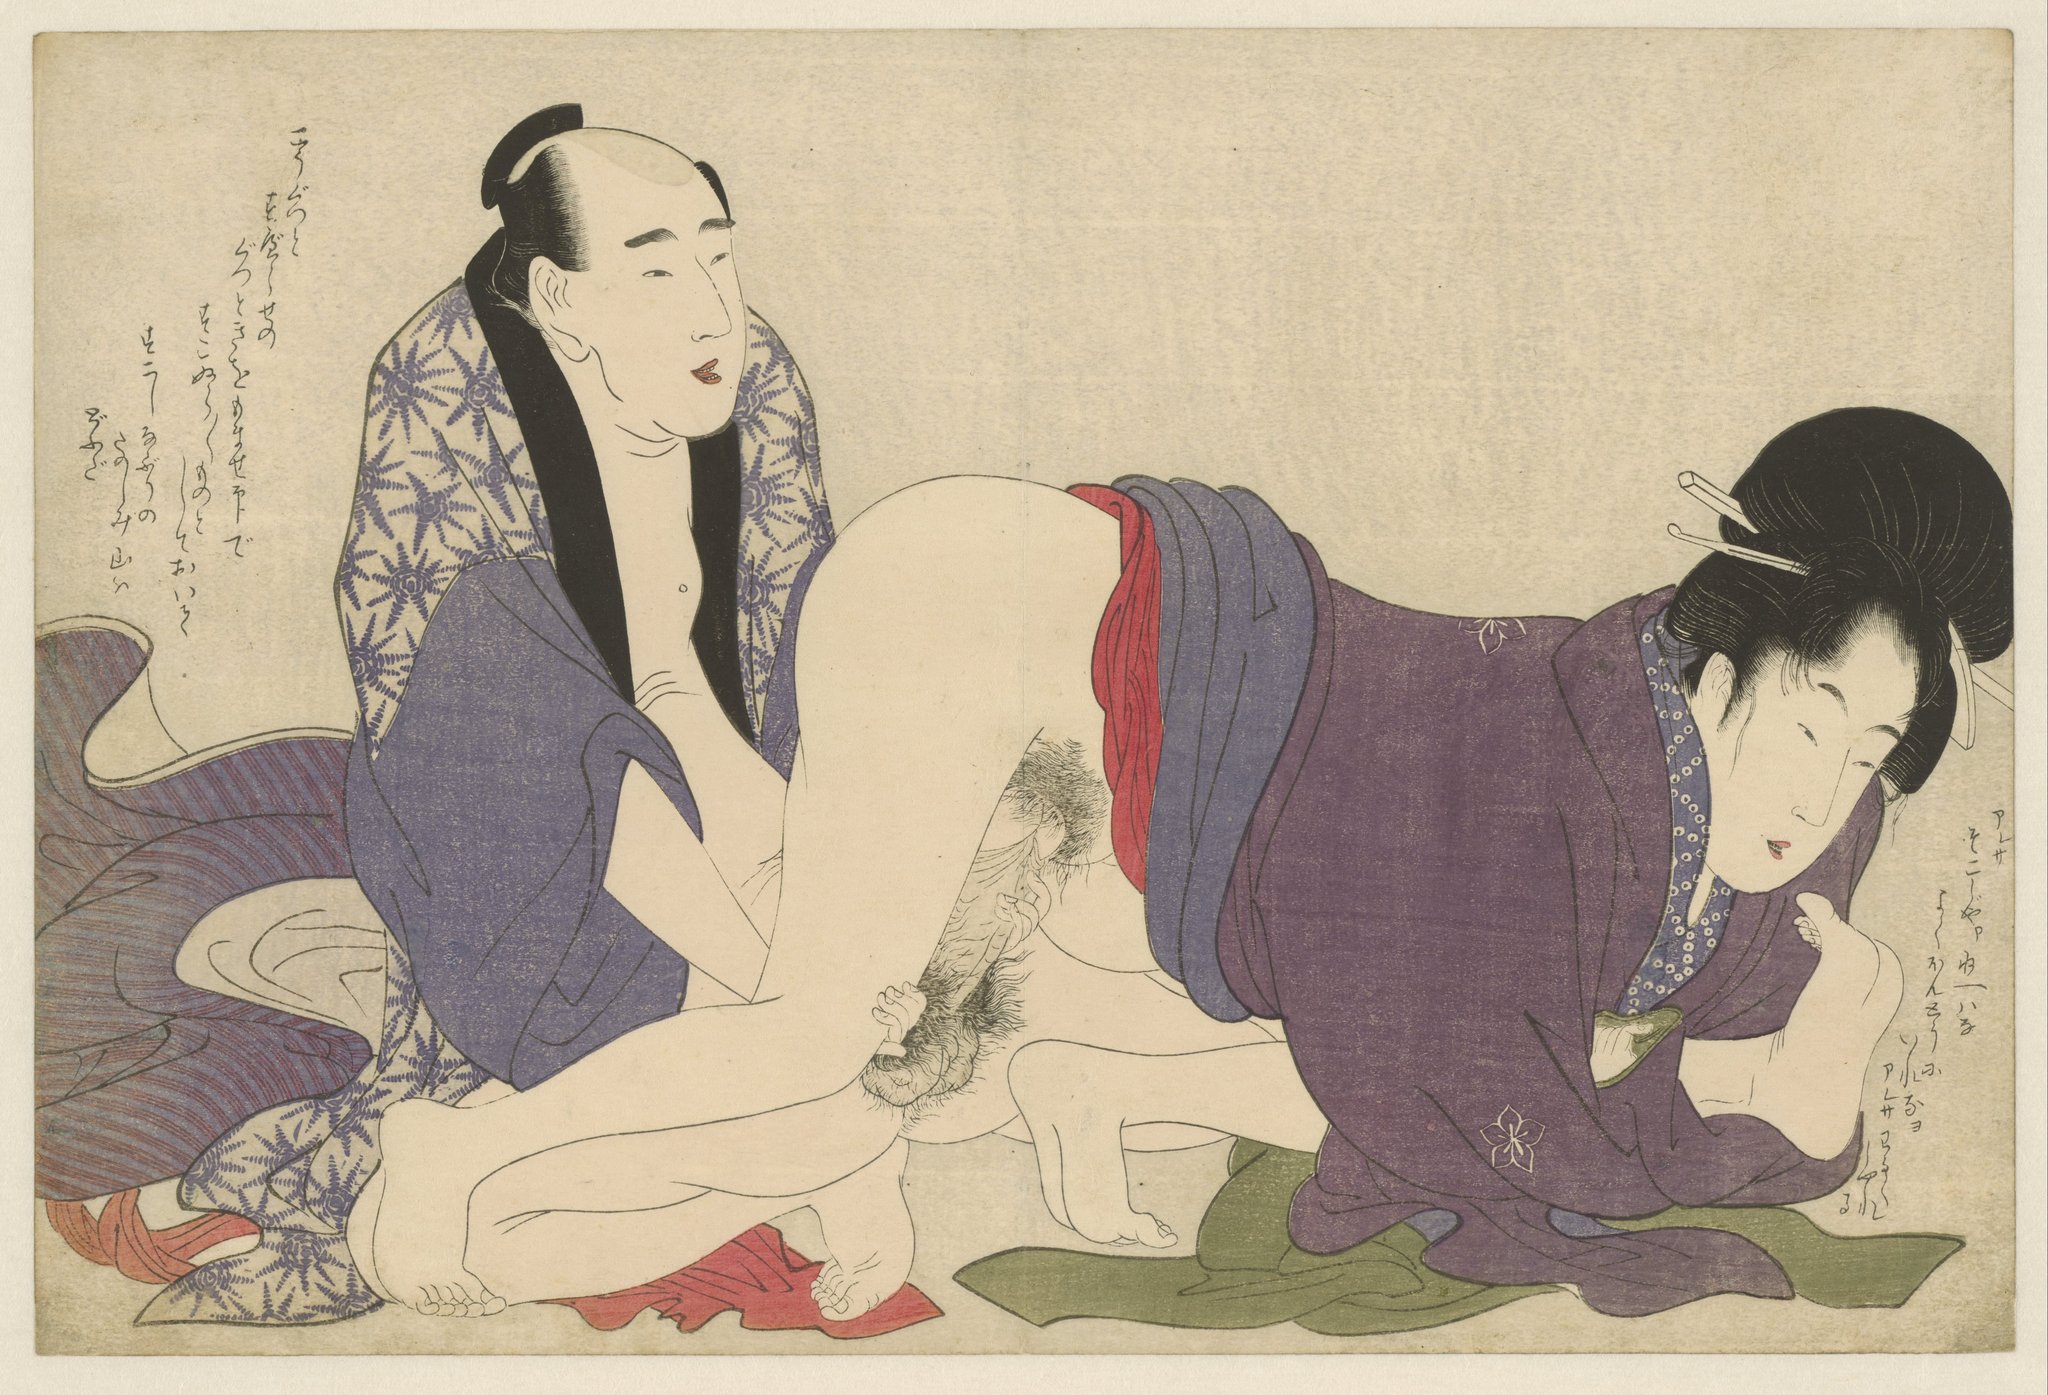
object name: shunga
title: Ouder getrouwd stel bedrijft de liefde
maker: kitagawa utamaro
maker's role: print maker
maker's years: 1753-1806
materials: paper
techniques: woodcut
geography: japan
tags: coitus, cohabiting, sexual intercourse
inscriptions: collector's mark: Lugt 2760, collector's mark: Lugt 2228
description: Oudere getrouwde man en vrouw bedrijven de liefde, waarbij zij de enkel van haar man vasthoudt. Zesde van dertien prenten uit het album Negai no itoguchi (ook wel vertaald met: The prelude to desire).